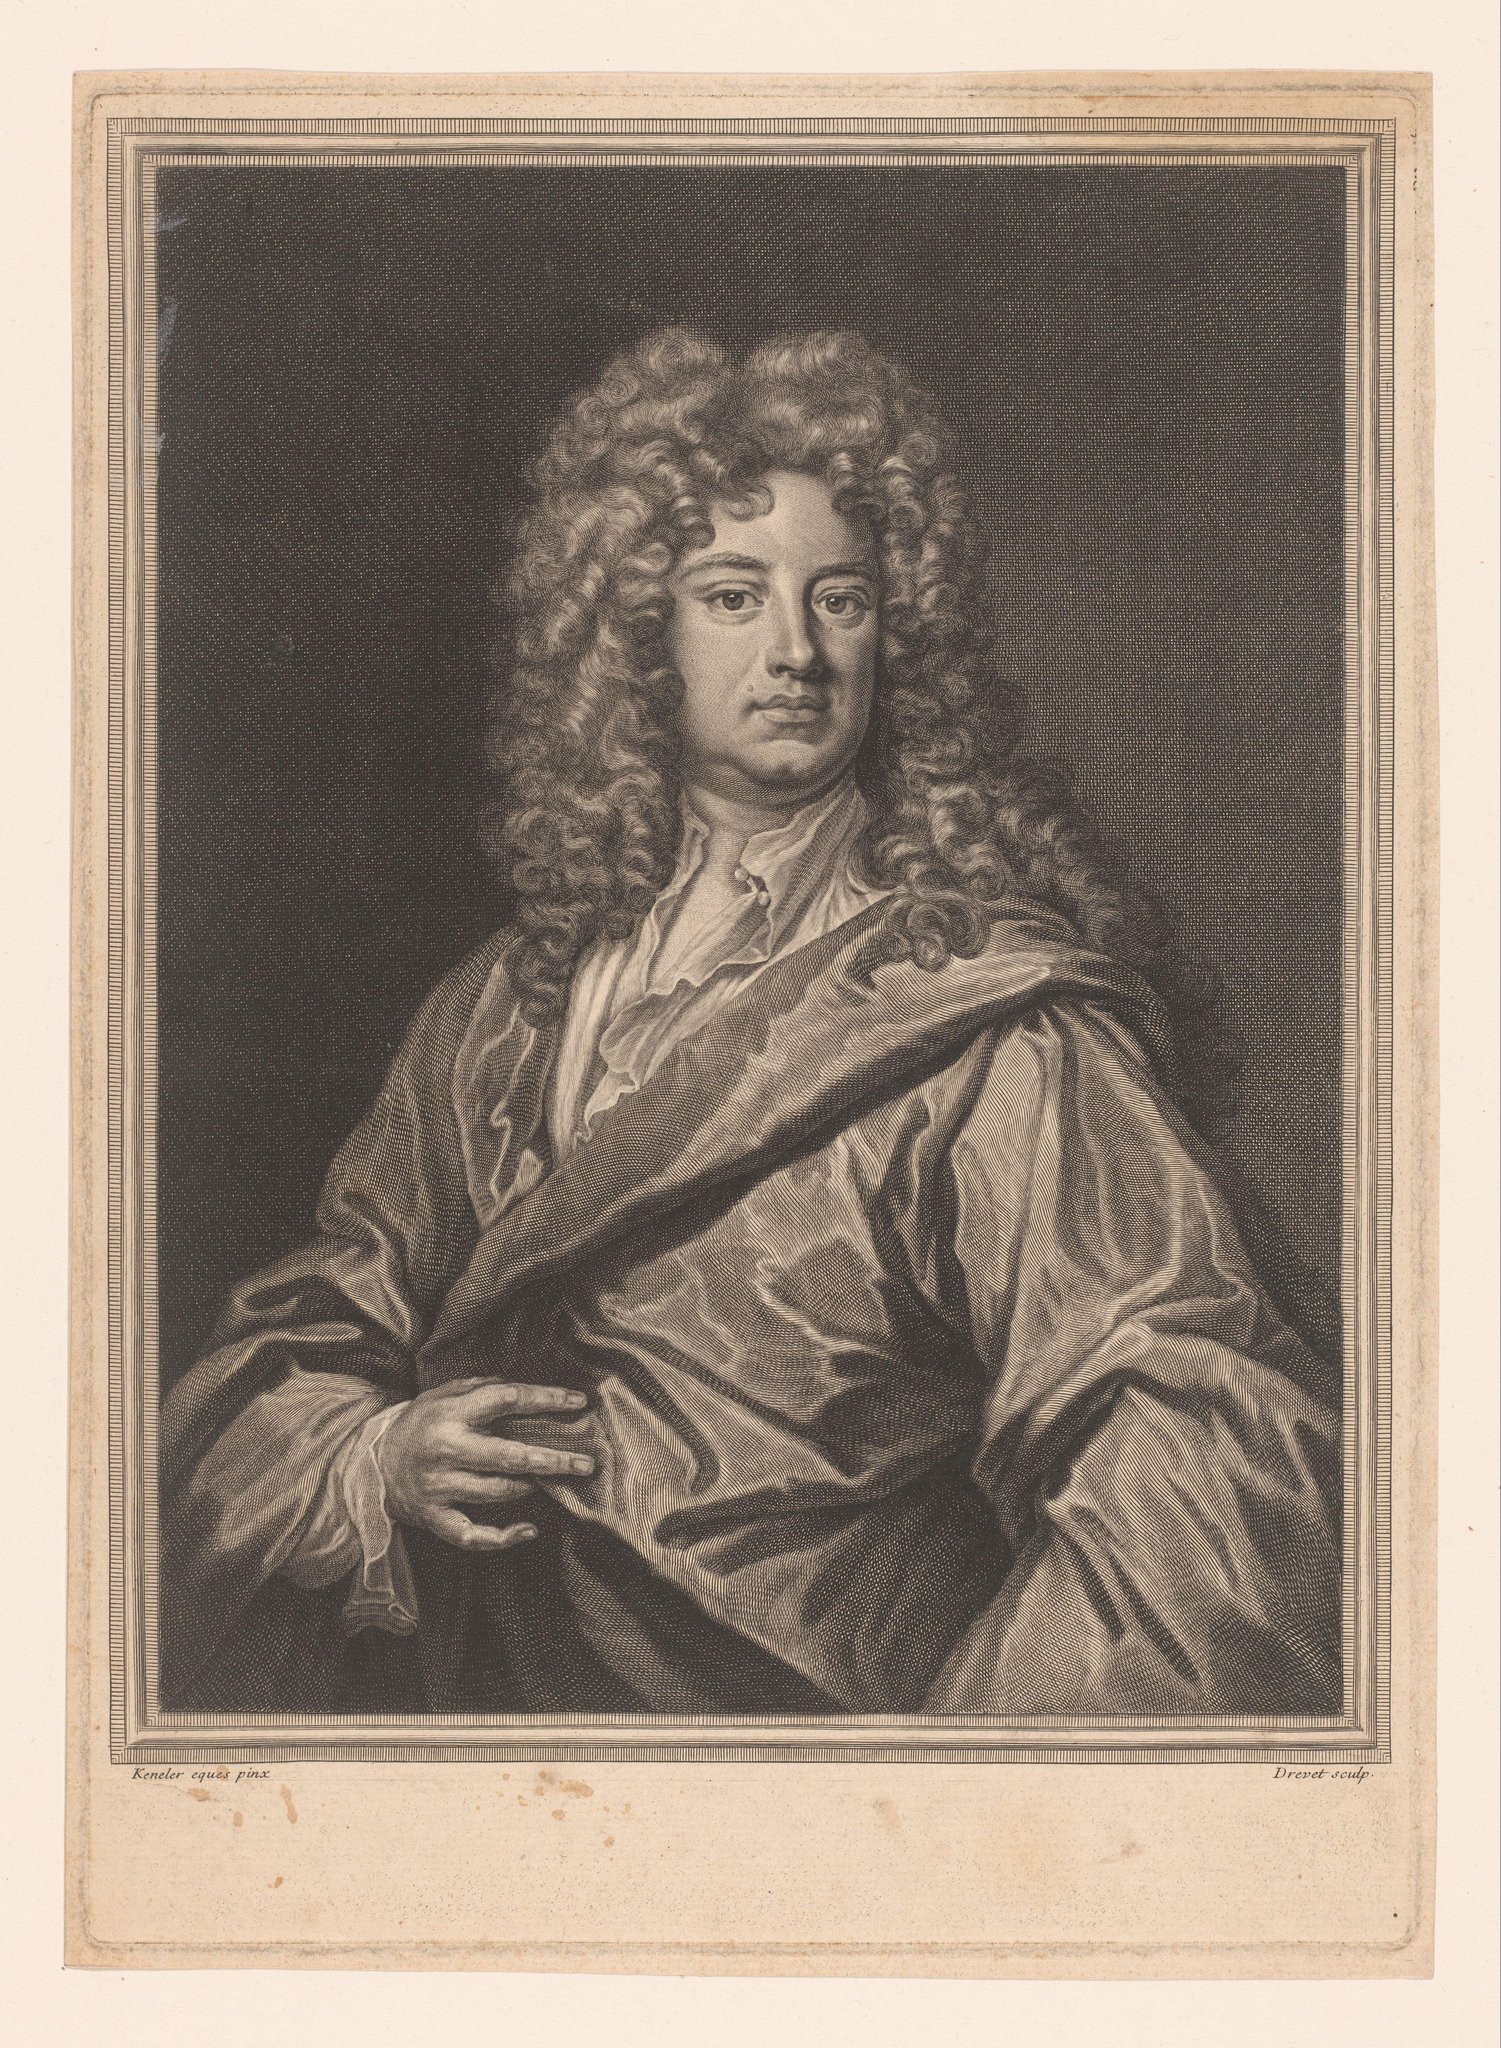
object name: print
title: Portret van Charles Montague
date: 1673-1738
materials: paper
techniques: engraving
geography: france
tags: earl, historical persons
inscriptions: collector's mark: Lugt 151, collector's mark: Lugt 2228, collector's mark: ‘IYC’